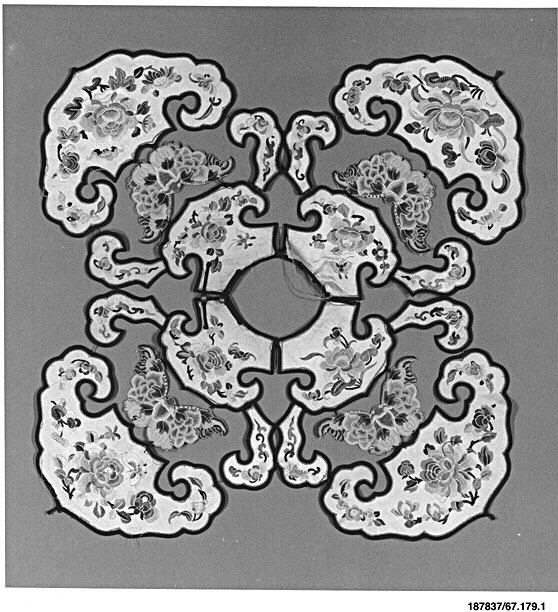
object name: cloud collar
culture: chinese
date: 1801-1900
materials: metal thread, silk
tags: butterflies,flowers